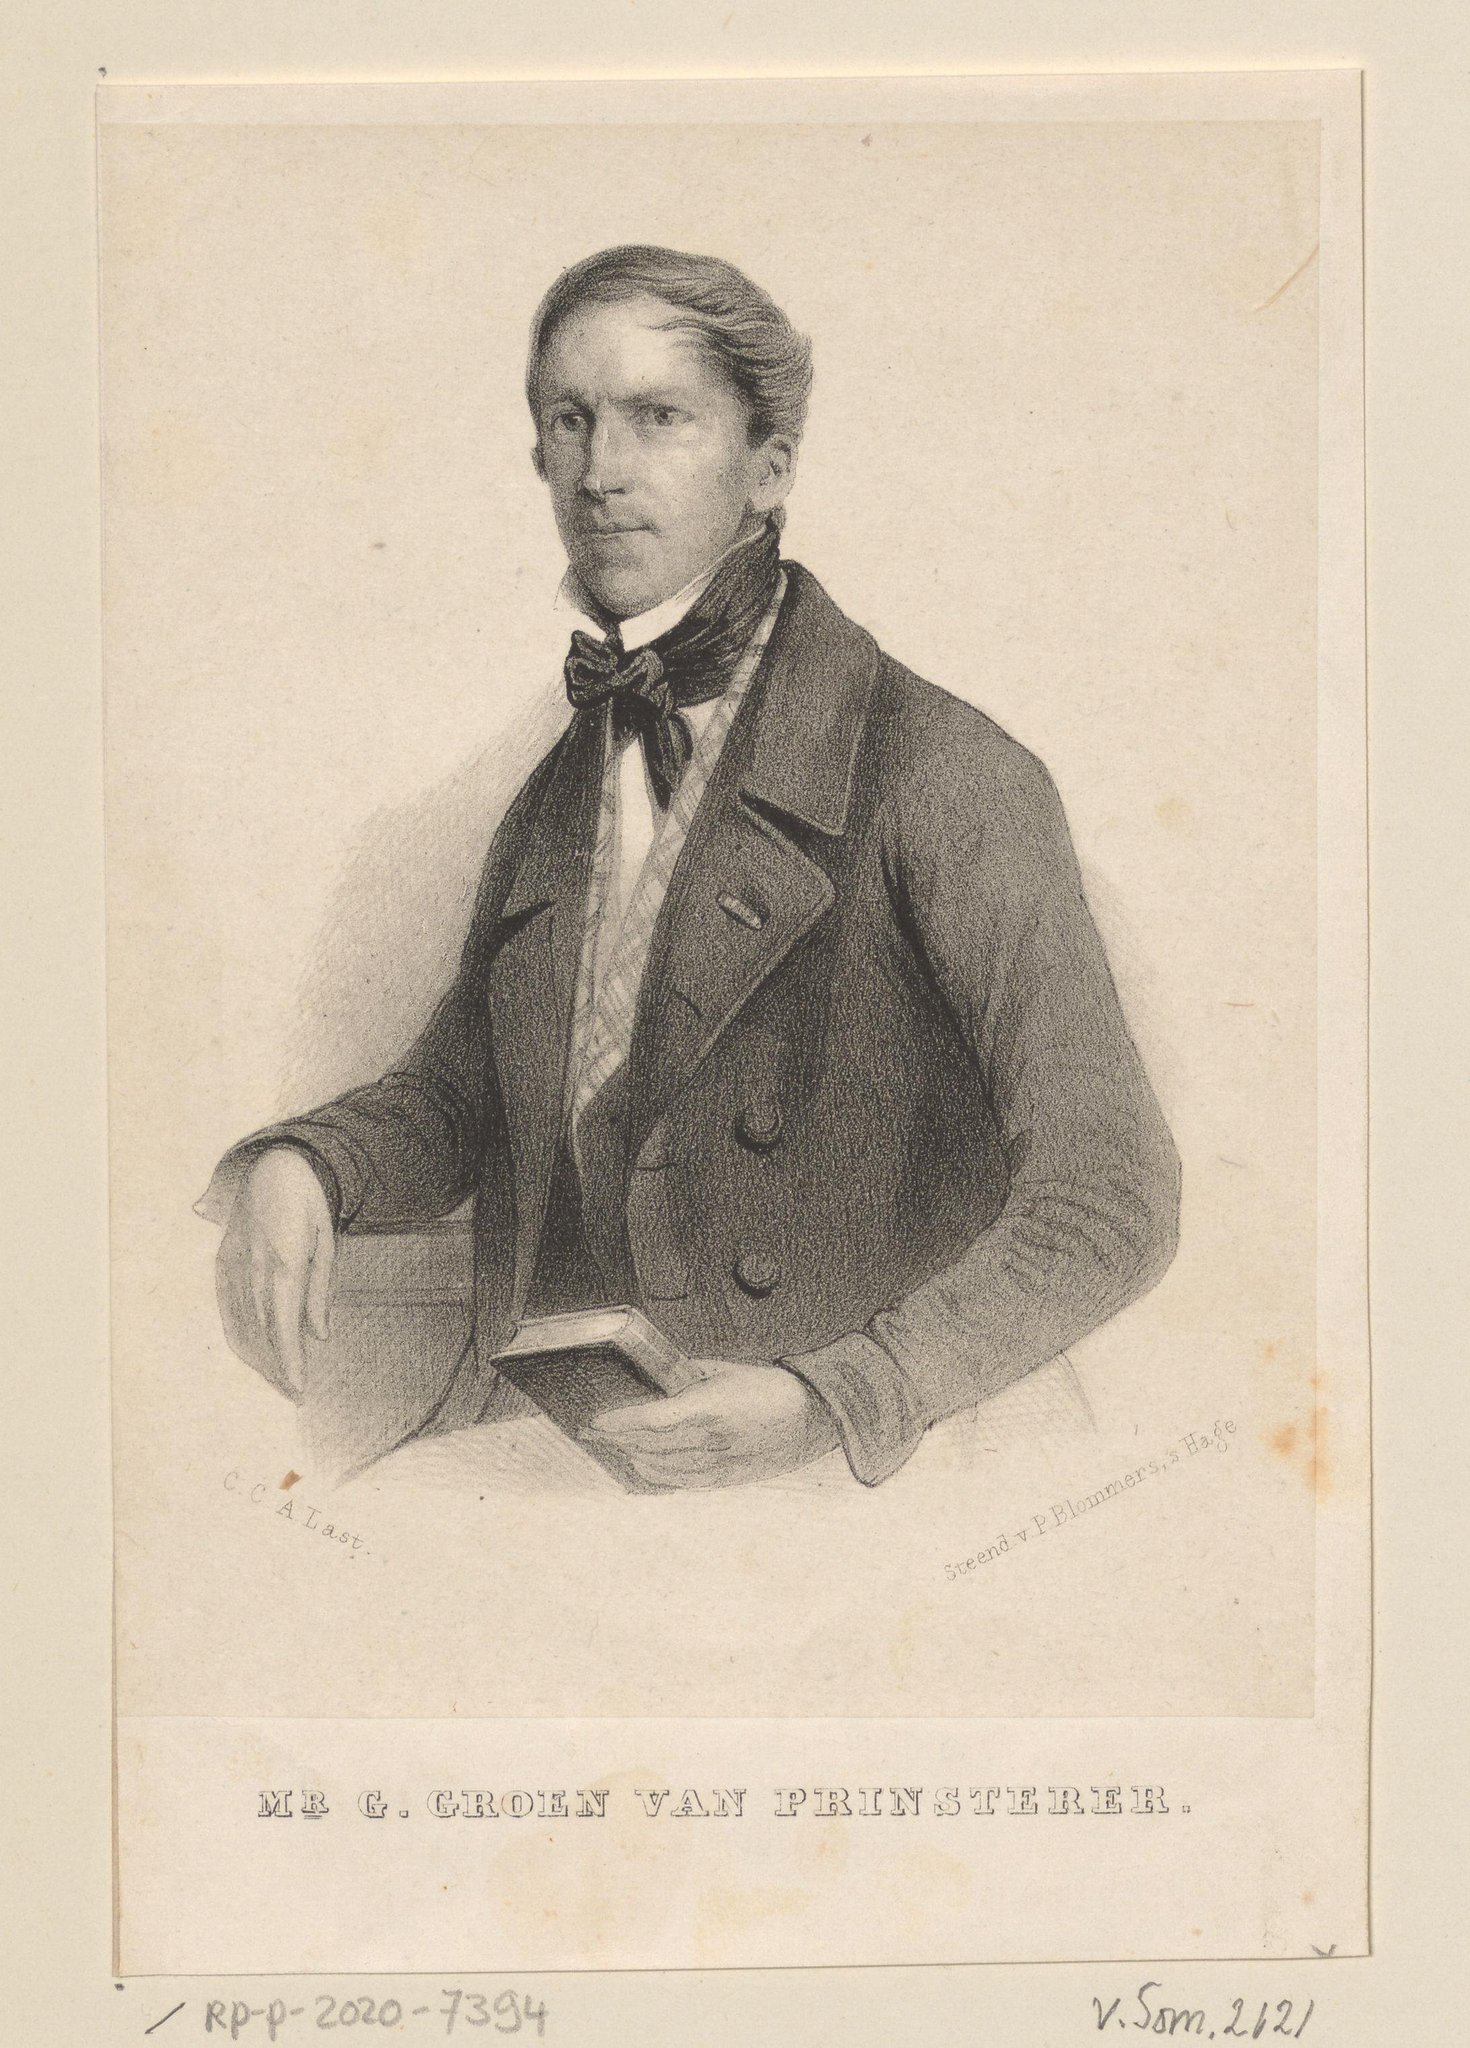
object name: print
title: Portret van Guillaume Groen van Prinsterer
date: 1842-1887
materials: paper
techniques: lithograph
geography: the hague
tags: guillaume groen van prinsterer, historical persons, portrait of a writer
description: Prent mogelijk uit: De Maandelijksche Kronijk 1 (1853).